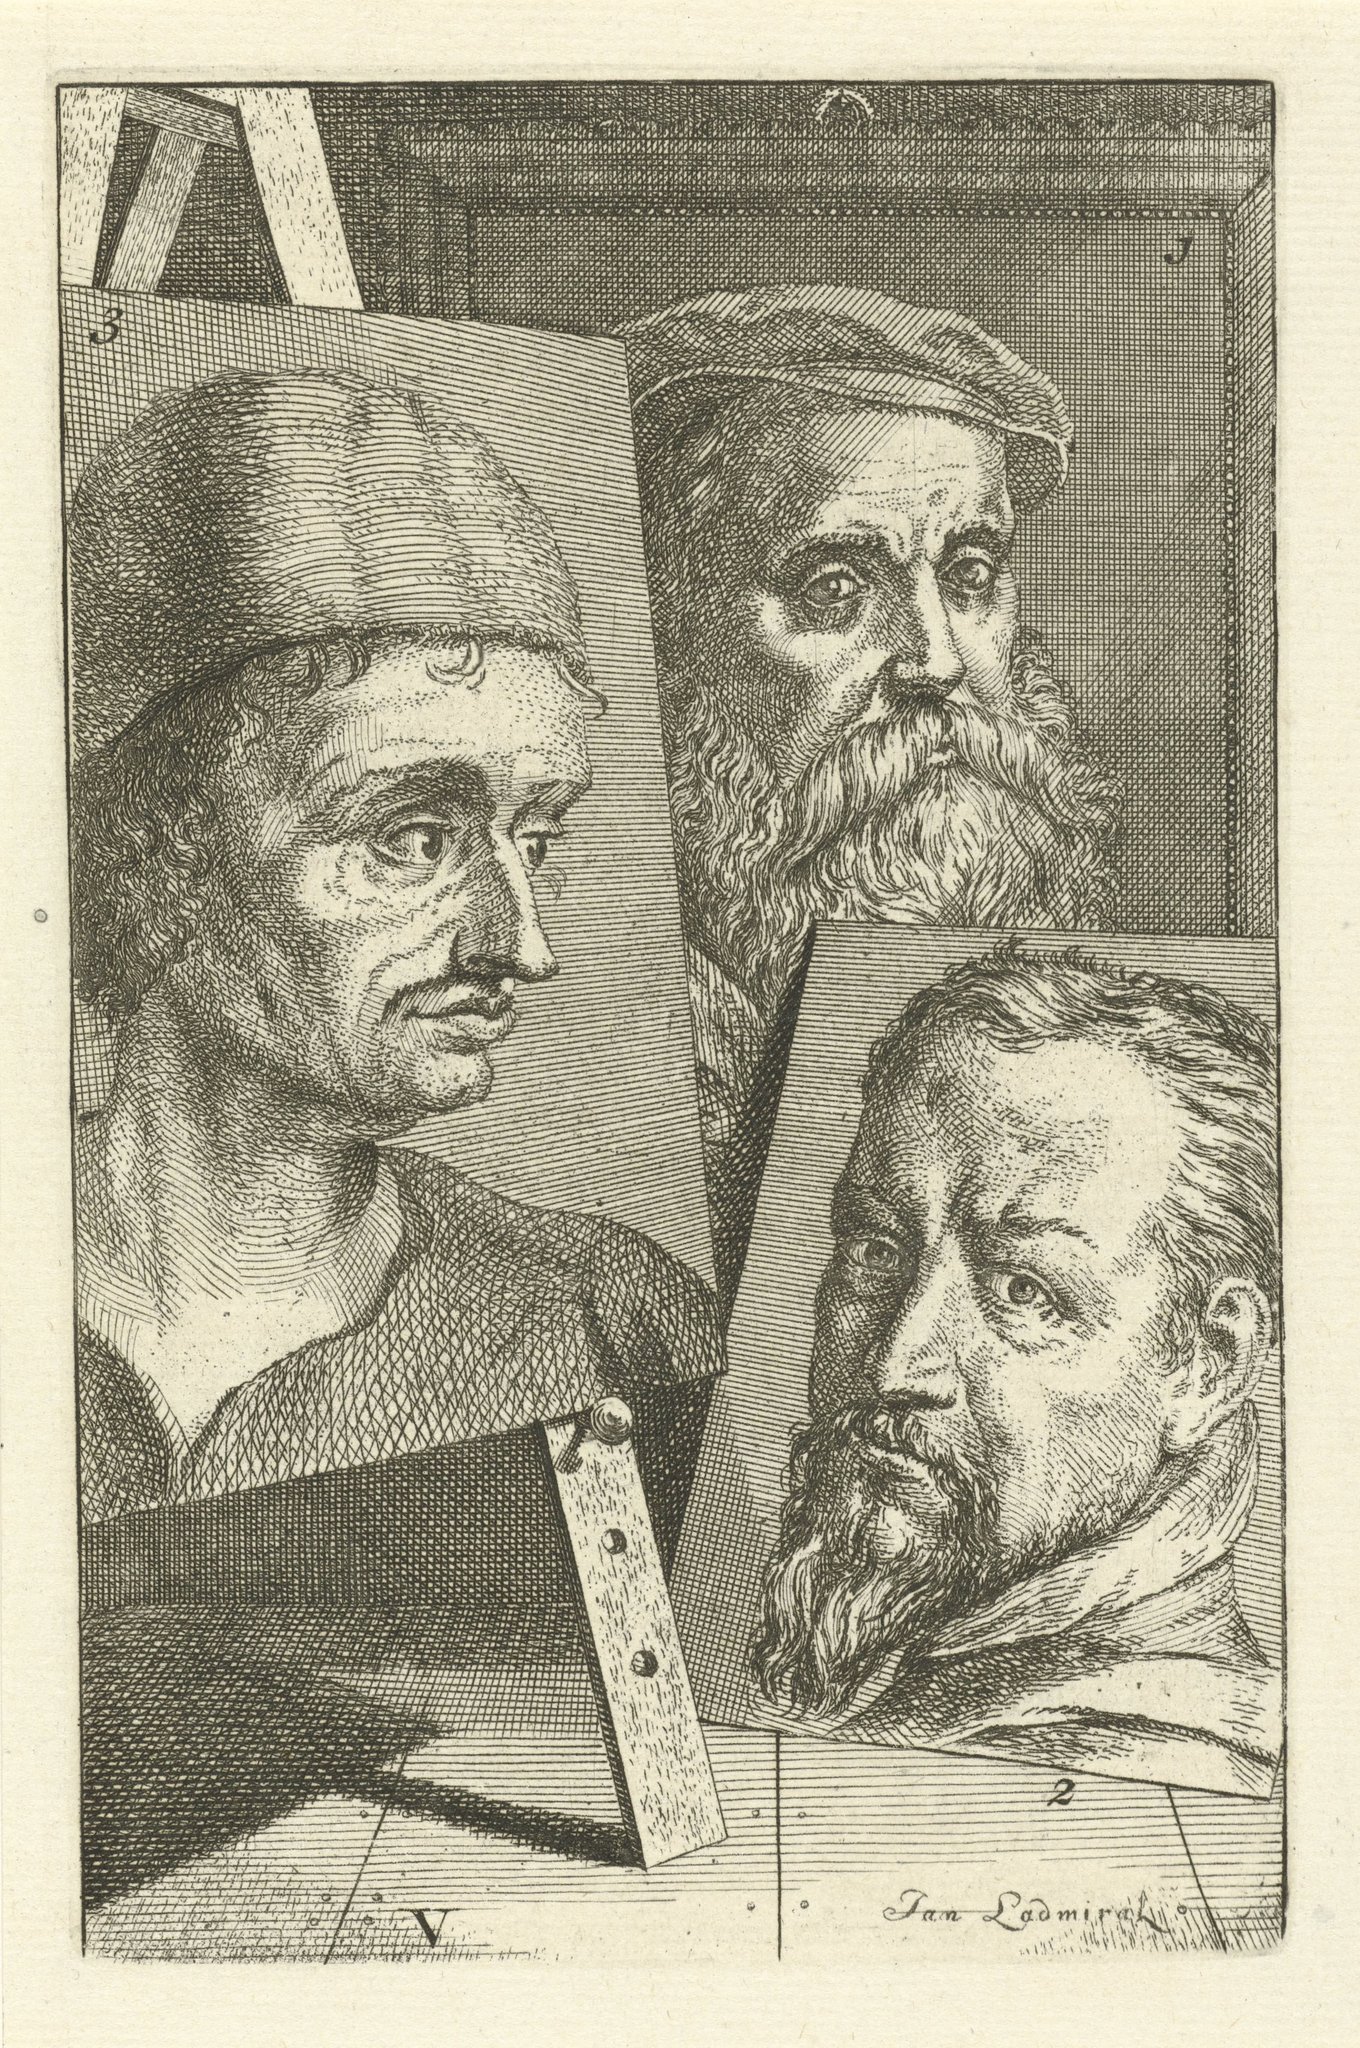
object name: book illustration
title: Portretten van Willem Key, Frans Floris en Pieter Aertsen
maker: jan l admiral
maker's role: draughtsman, print maker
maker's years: 1699-1773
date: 1764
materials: paper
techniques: etching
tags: print maker, draughtsman, pieter aertsen, frans floris (i), antwerp, painter, willem key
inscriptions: collector's mark: Lugt 2228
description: Prent opgenomen in: Mander, Karel van; Jongh, Jacobus de (vert.). Het leven der doorluchtige Nederlandsche en eenige Hoogduitsche schilders. Amsterdam: Steven van Esveldt, 1764.